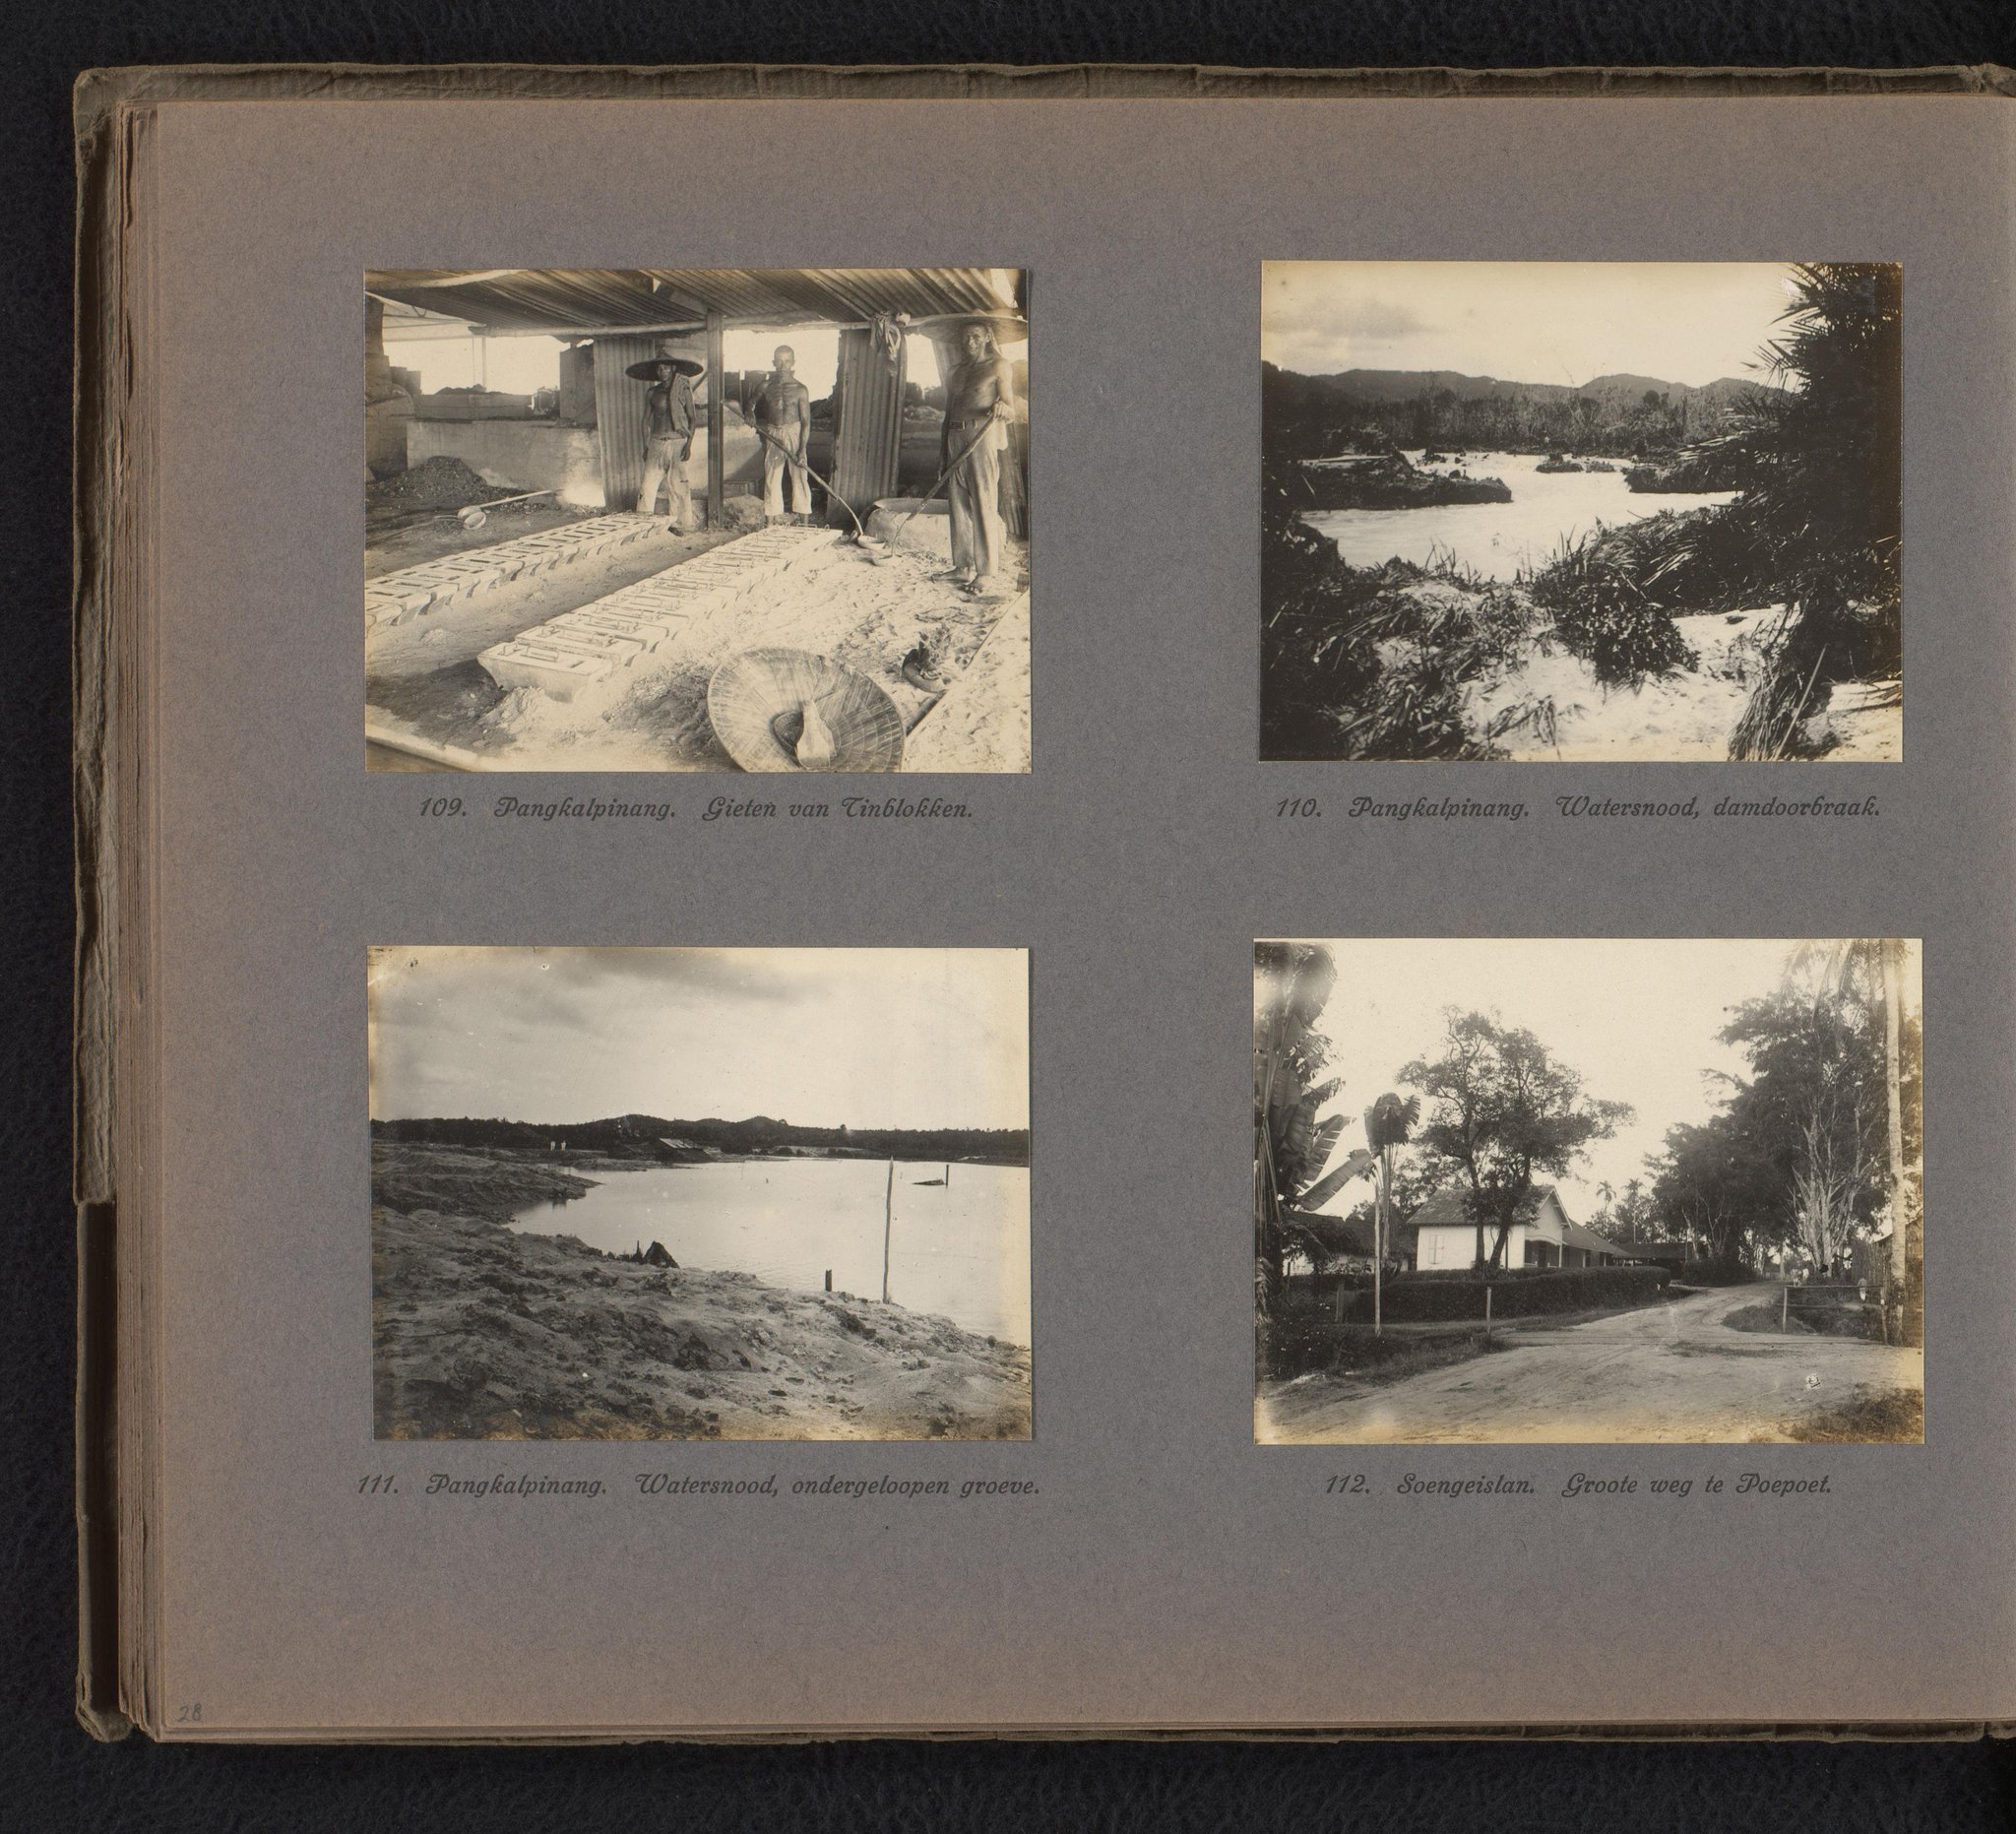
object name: photograph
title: Gezichten te Pangkalpinang en Soengeislan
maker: Anonymous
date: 1907-1919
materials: cardboard, photographic support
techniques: gelatin silver print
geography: bangka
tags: robert julius boers, colonial system, opencast mine; strip mining, minerals and metals: tin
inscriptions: inscription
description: Albumblad met vier foto's genummerd 109-112 van verschillende gezichten te Pangkalpinang en Soengeislan op Banka: gieten van tin, ondergelopen groeve, dorpsgezicht. Onderdeel van het Banka-Album met foto's over het eiland Banka en de tinwinning door het staatsbedrijf de Banka-tinwinning in de periode ca. 1907-1919.